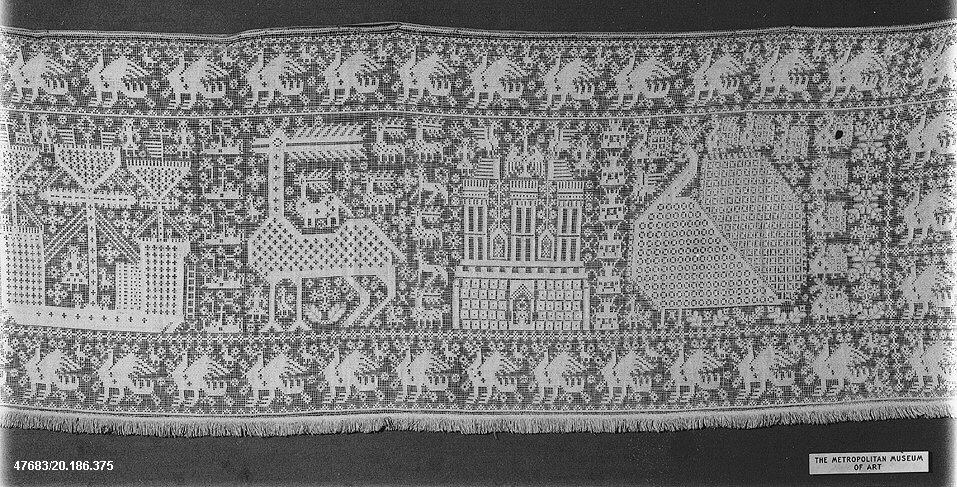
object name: valance wedding train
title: Valance (wedding train)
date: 1501-1600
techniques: embroidery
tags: birds